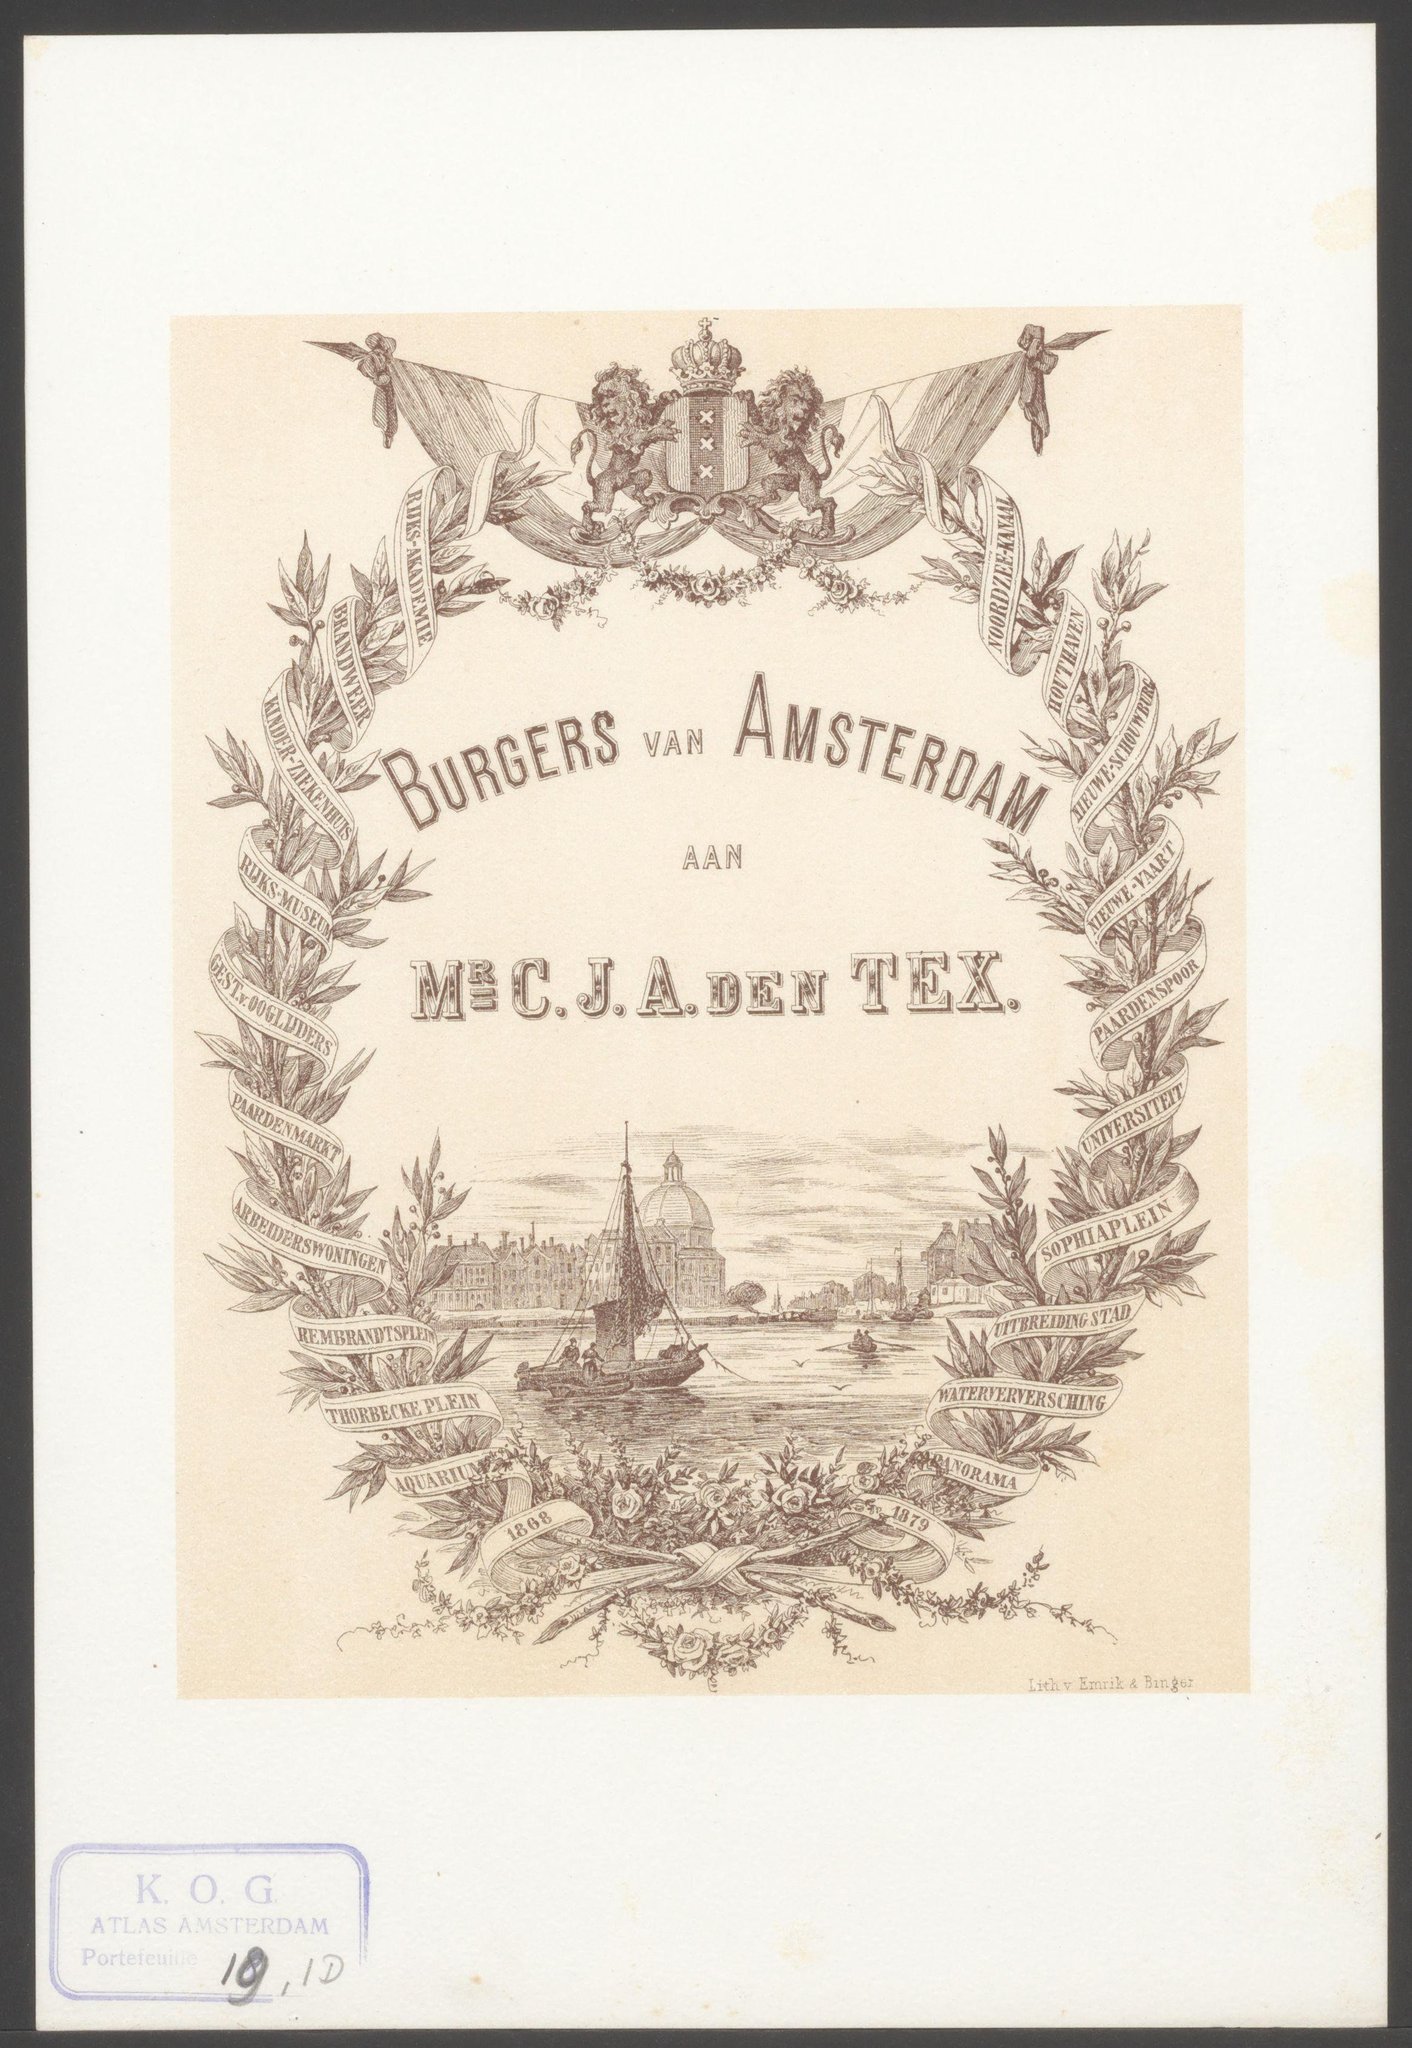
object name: print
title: Burgers van Amsterdam aan mr. C.J.A. den Tex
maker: Anonymous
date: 1880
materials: paper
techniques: tone lithography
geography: haarlem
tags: cornelis jacob arnold den tex, mayor, burgomaster, commemoration, jubilee, amsterdam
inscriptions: collector's mark: ‘19 1D’ Lugt 1641b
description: Onderwerpsrubriek binnen de Atlas Amsterdam: Herinneringen aan regeringsleden en hunne huisgezinnen [na 1800]. Onderdeel van een boekje gedrukt ter gelegenheid van het afscheid van Cornelis Jacob Arnold den Tex als burgemeester van Amsterdam op 31 december 1879.